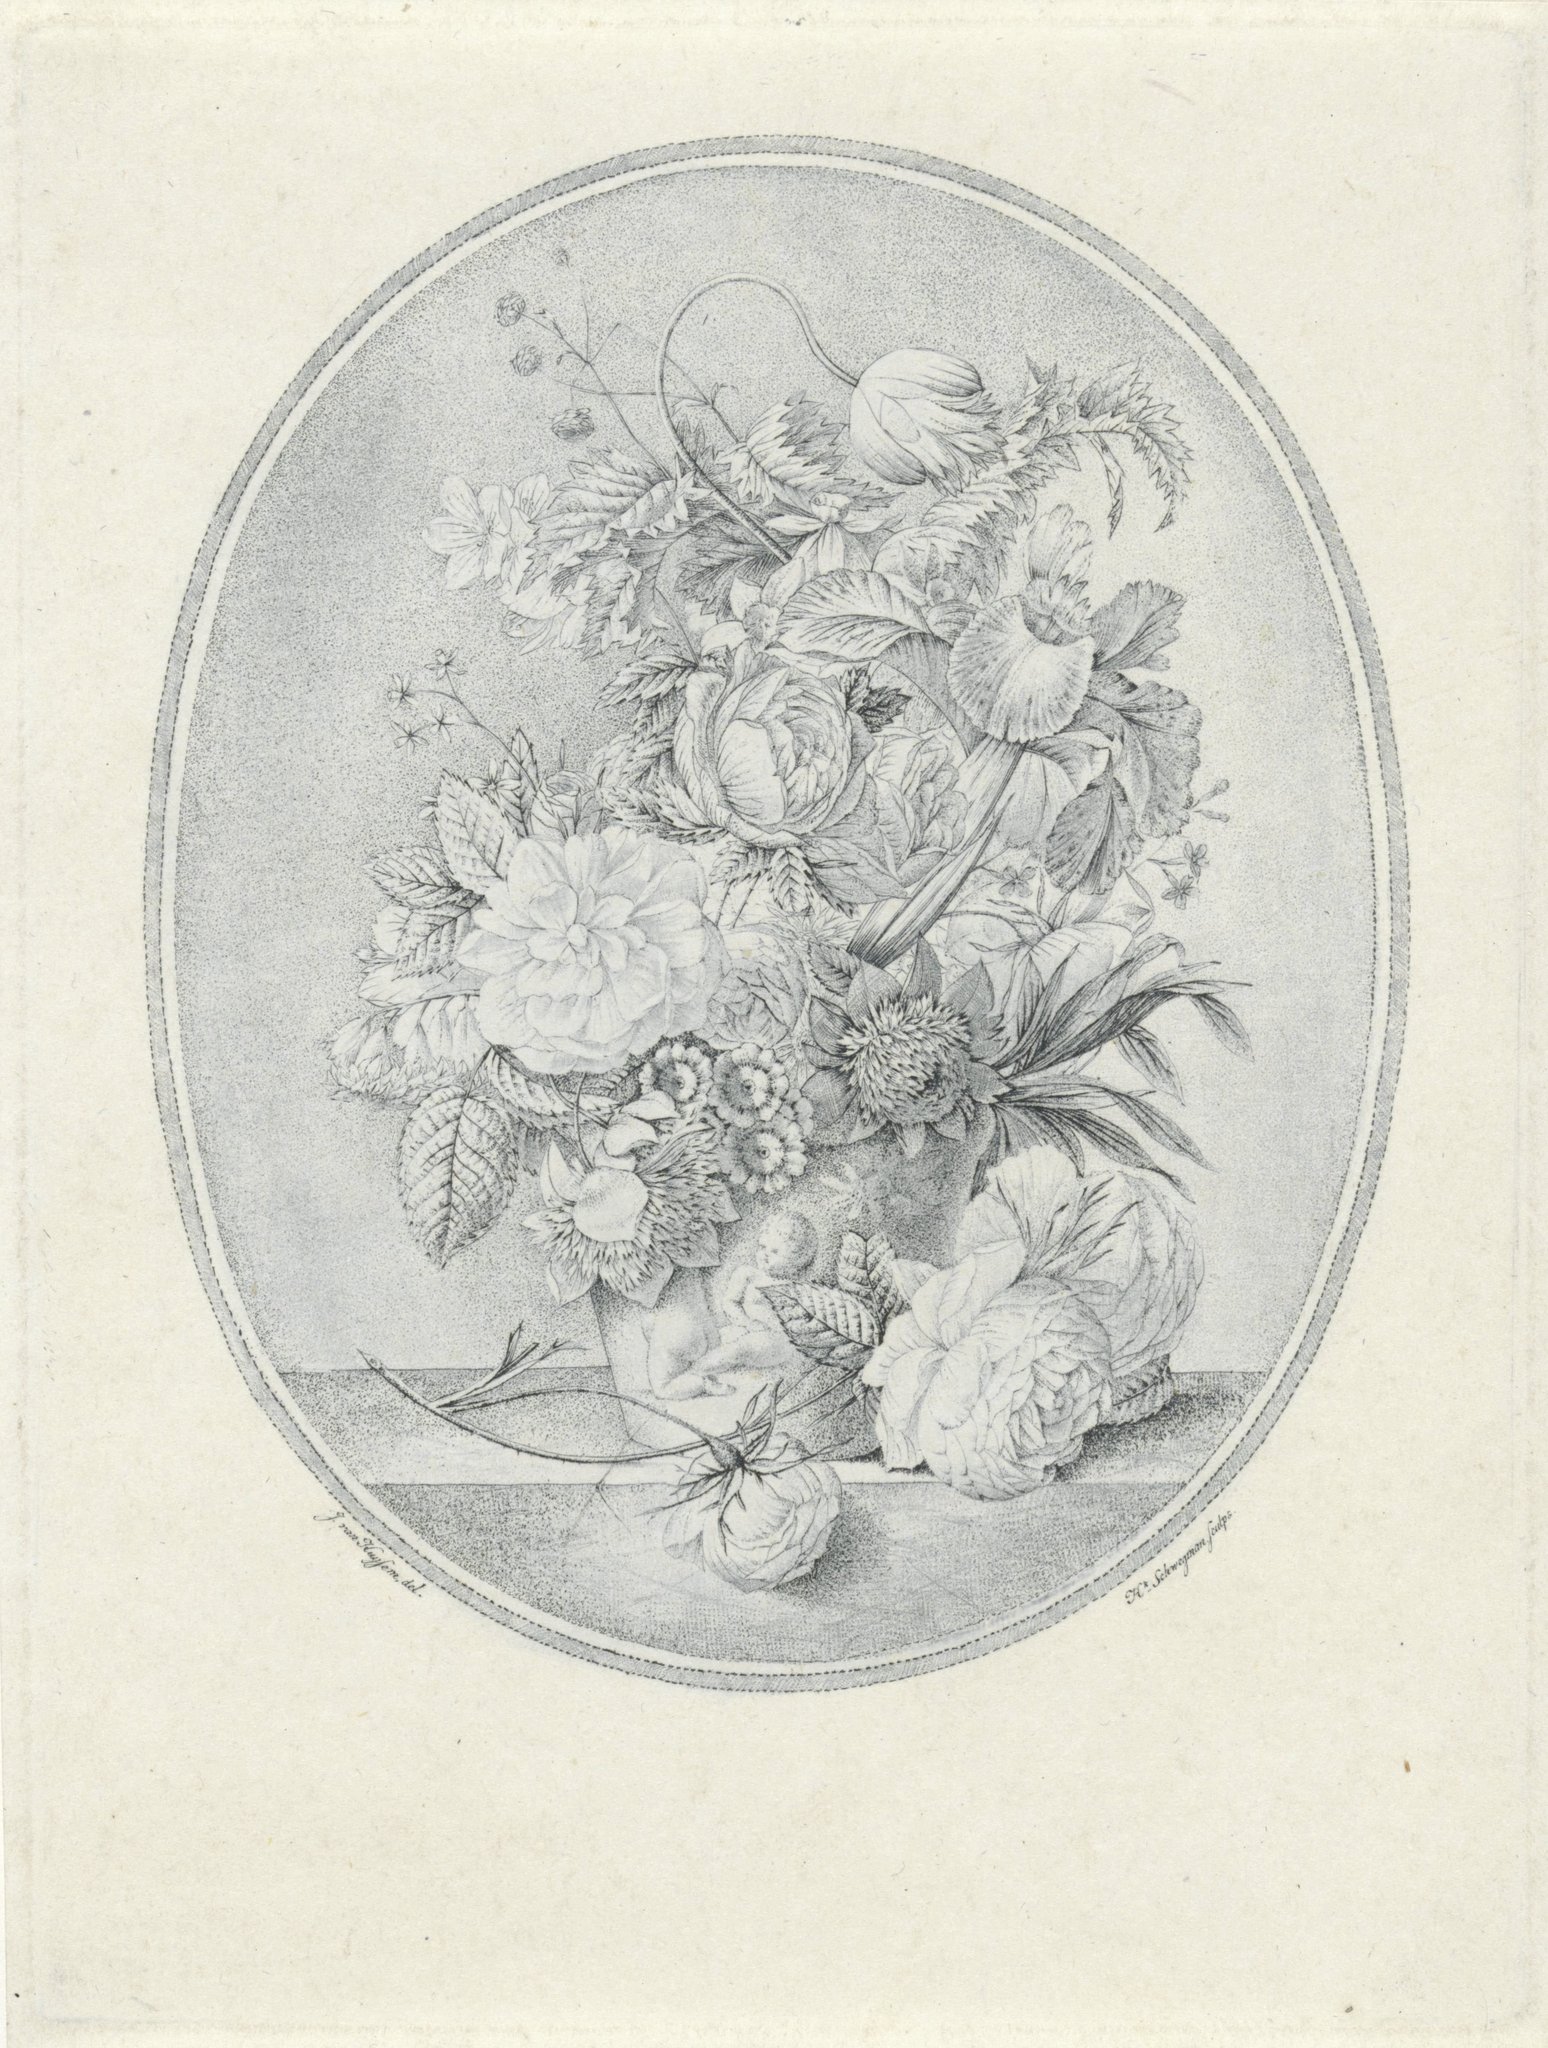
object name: print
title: Bloemenvaas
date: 1771-1816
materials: paper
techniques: etching, roulette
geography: haarlem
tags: flowers in a vase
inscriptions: signature and date: ‘r.o. : H. Schwegman sculps. l.o. : J. van Huysum del.’, collector's mark: Lugt 2228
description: Een vaas met bloemen, waaronder pioenrozen. Op de plint ligt een rozentak.